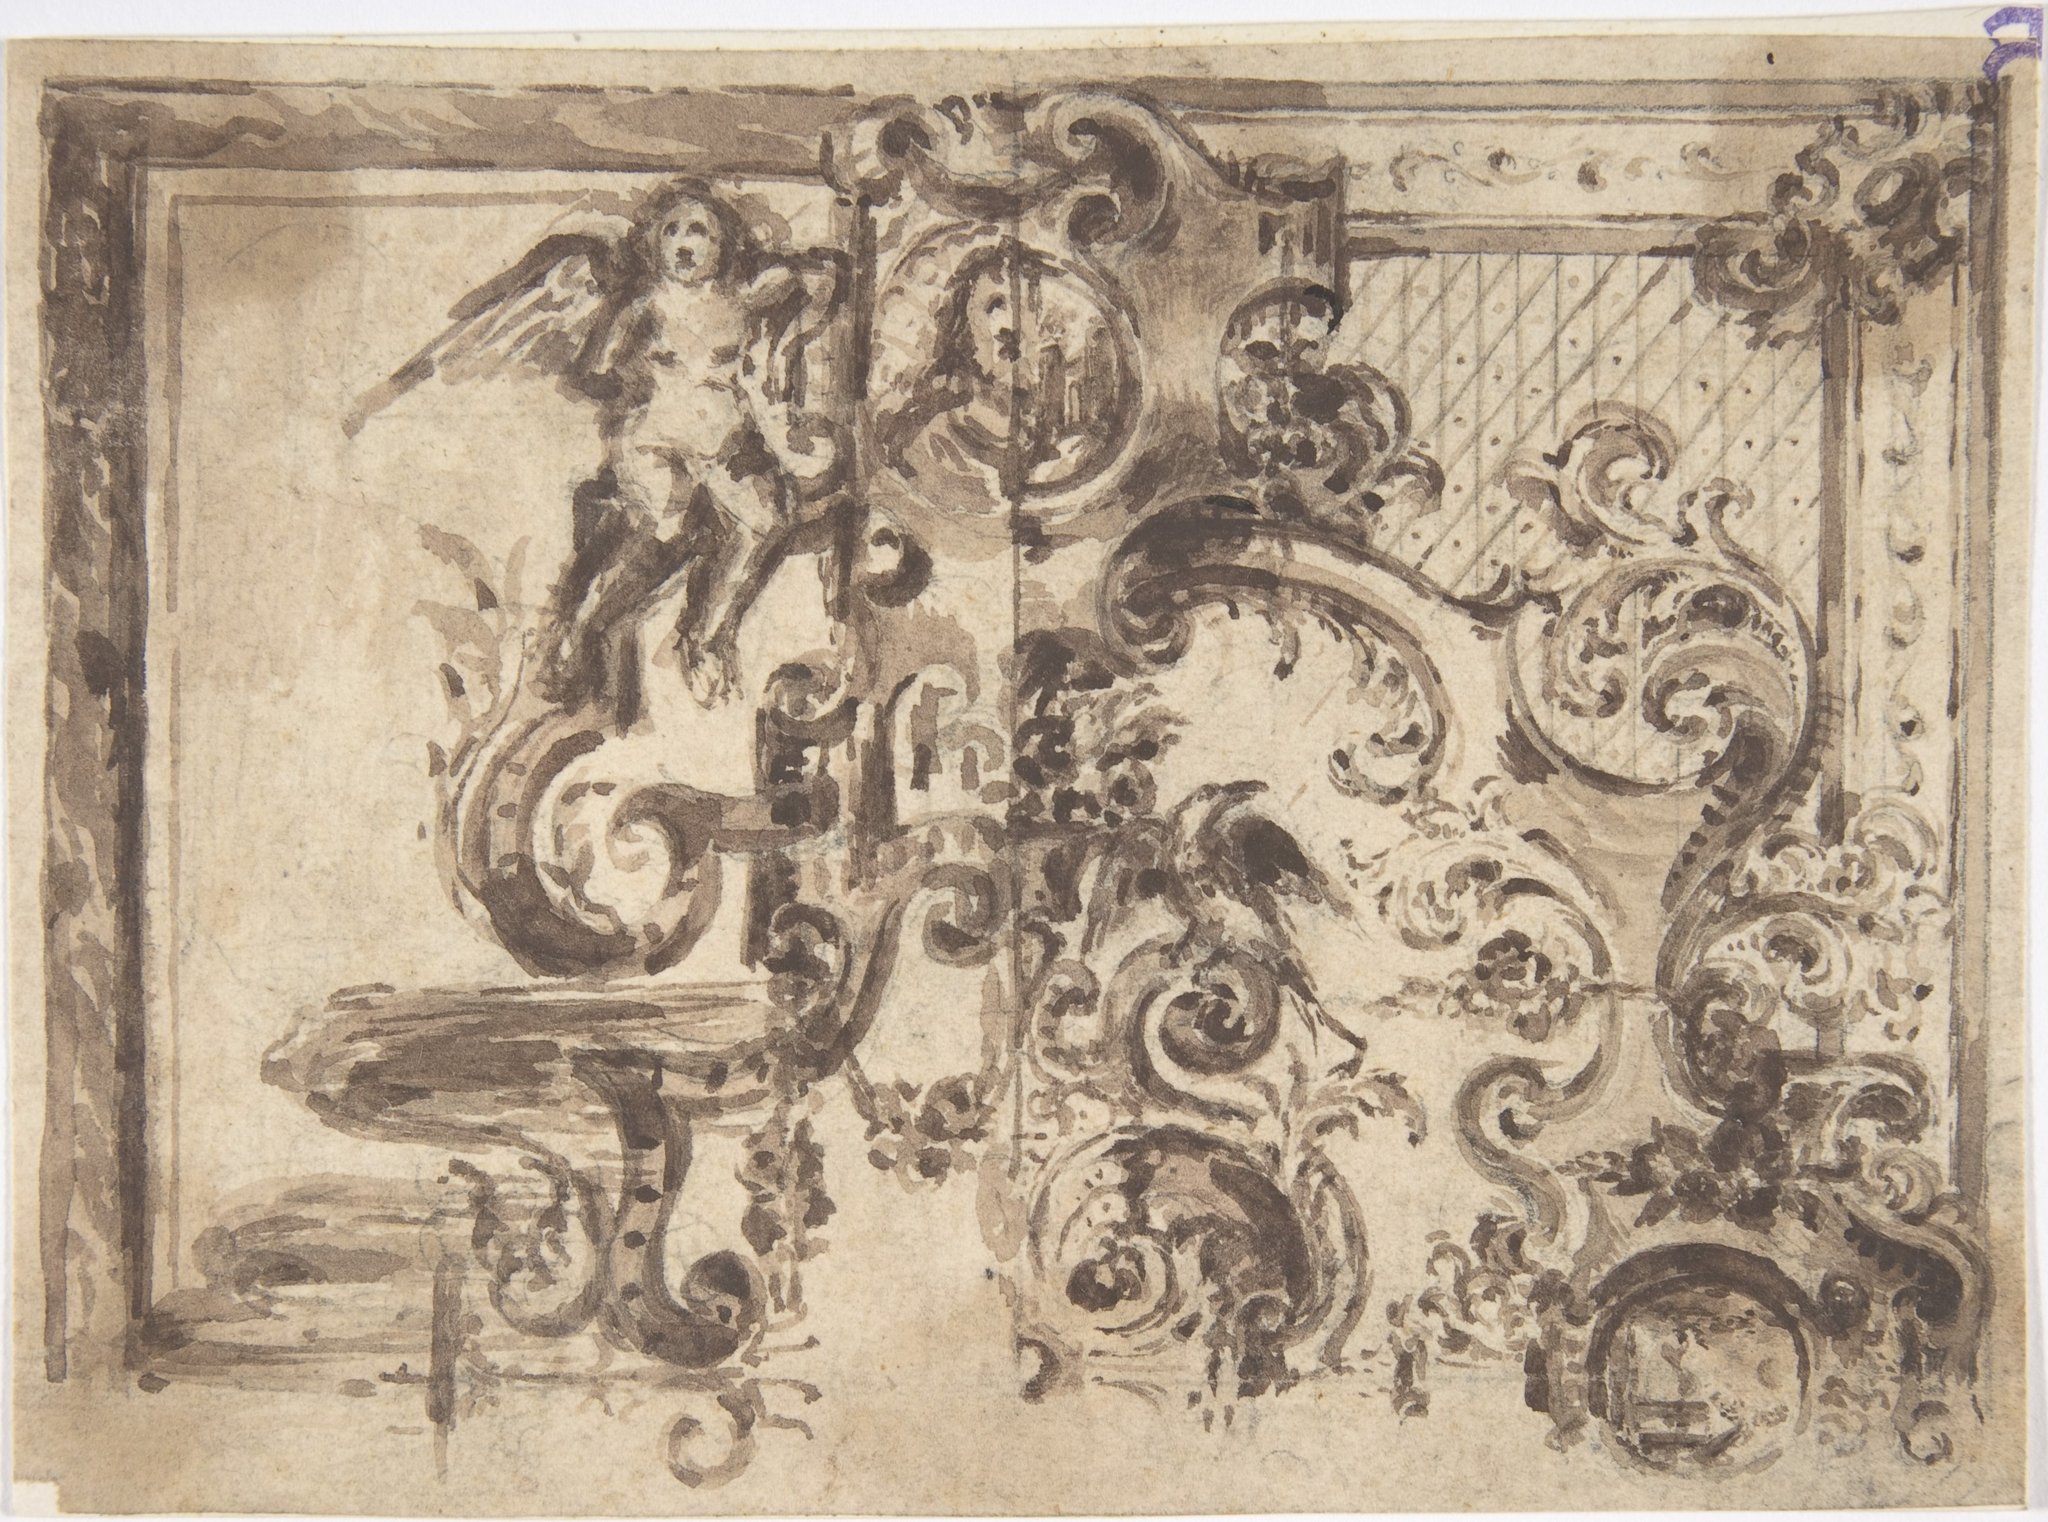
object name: drawing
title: Design for an Overmantel or Door with a Variant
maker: anonymous, french, 19th century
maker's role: artist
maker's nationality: french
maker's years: 1800-1900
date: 1801-1900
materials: crayon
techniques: brush, wash